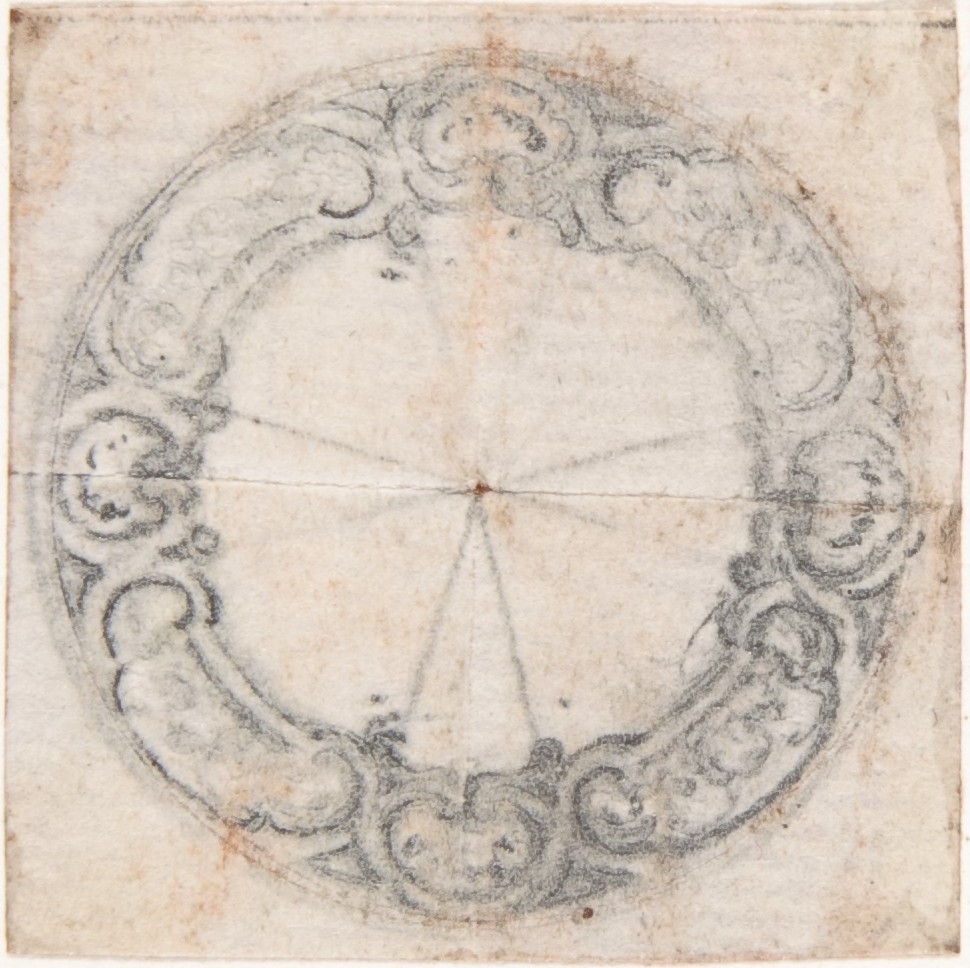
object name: drawing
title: Design for a Watch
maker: hubert françois gravelot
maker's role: artist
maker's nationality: french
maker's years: 1699-1773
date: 1701-1800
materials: chalk, graphite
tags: watches